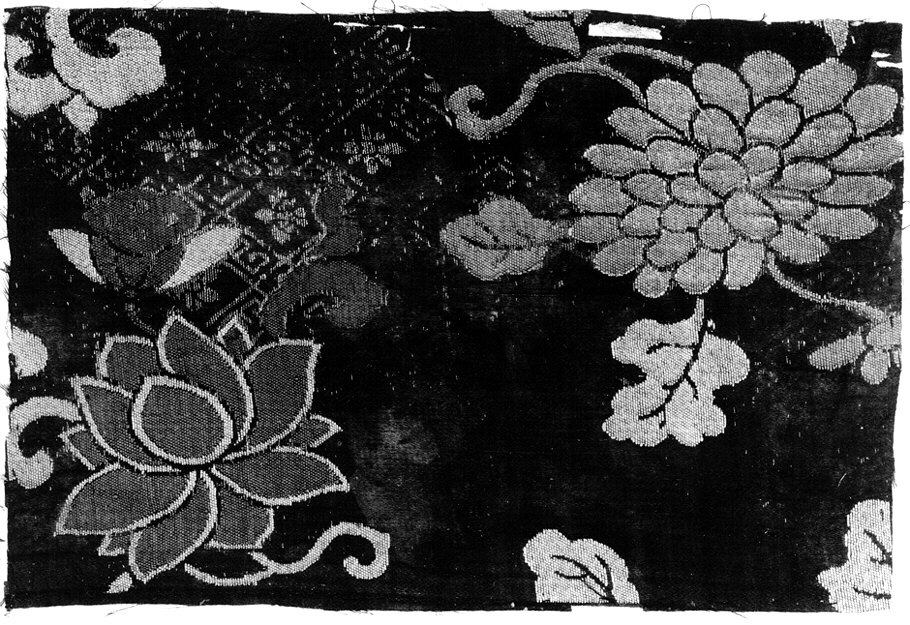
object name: piece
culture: chinese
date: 1701-1733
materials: metal thread, silk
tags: flowers